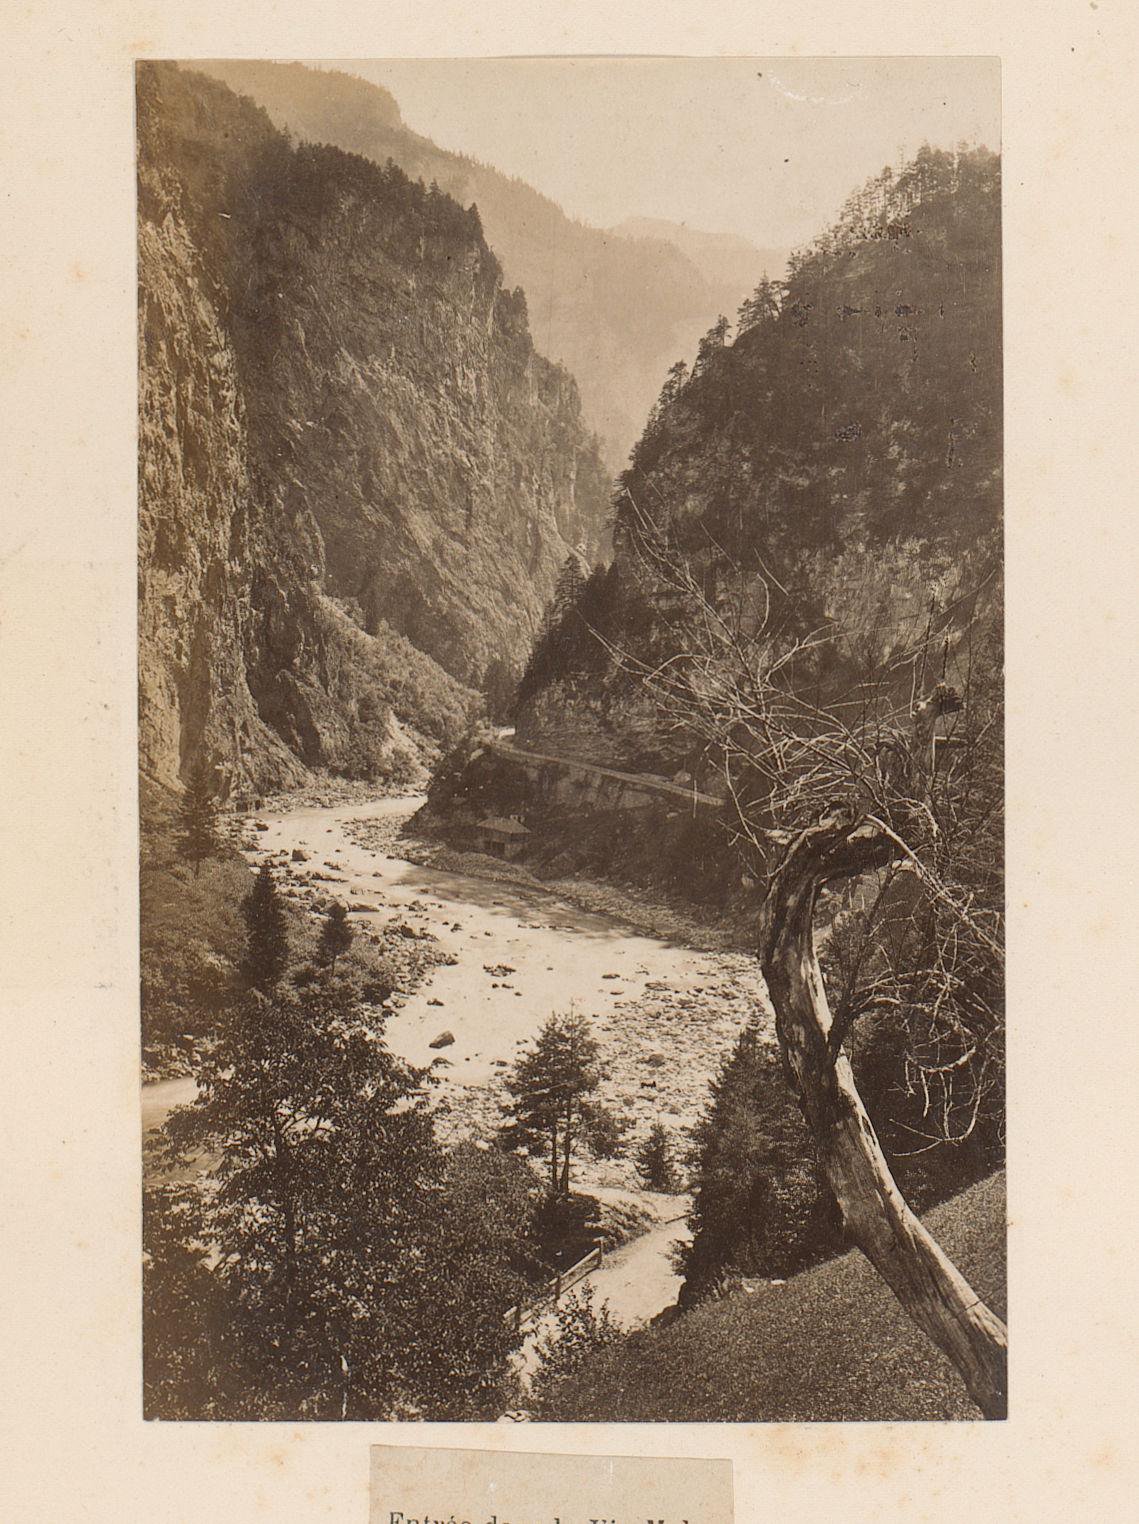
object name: photograph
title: Begin van de Via Mala tussen Thusis en Zillis-Reischen, Zwitserland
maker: Anonymous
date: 1860-1890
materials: paper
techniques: albumen print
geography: via mala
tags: ravine, chasm, abyss, canyon, road, path, brook